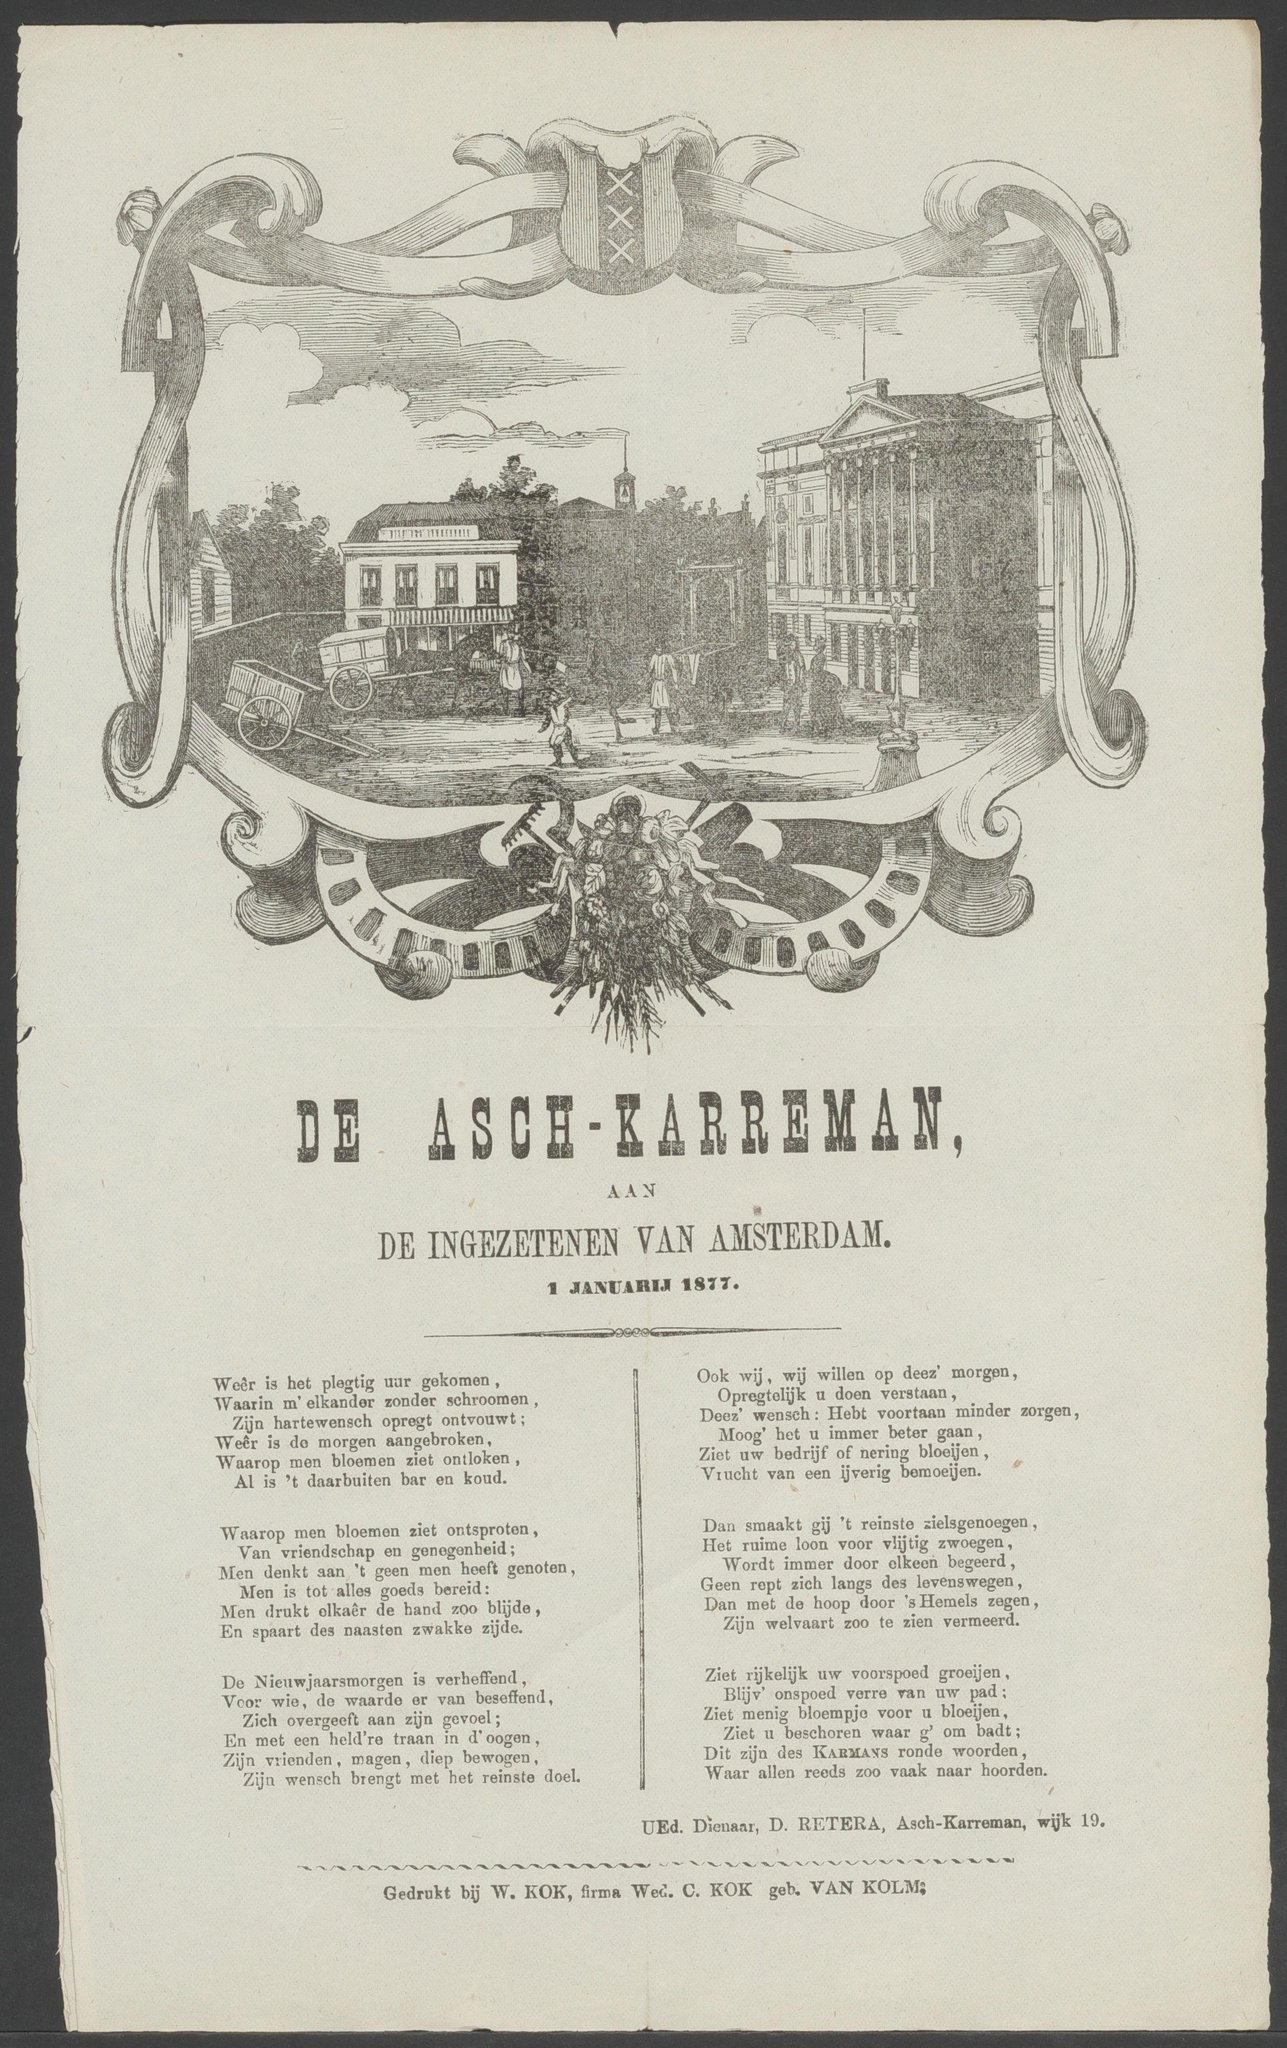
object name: new year card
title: De asch-Karreman, aan de ingezetenen van Amsterdam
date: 1876-1877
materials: paper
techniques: letterpress printing, engraving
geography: amsterdam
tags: street, garbage collection, amsterdam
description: Nieuwjaarswens van de Amsterdamse karrenman (askarrenman of vuilnisman) voor het jaar 1877. Vuilnismannen met hun karren op een plein. Met gedicht in twee kolommen. Van de vuilniskarman in de wijk no. 19: D. Retera. Onderwerpsrubrieken binnen de Atlas Zeden en Gewoonten: Zeden en gewoonten in engeren zin, Volksleven, Volksbladen, Nieuwjaars- en Kerstwenschen, Amsterdam.